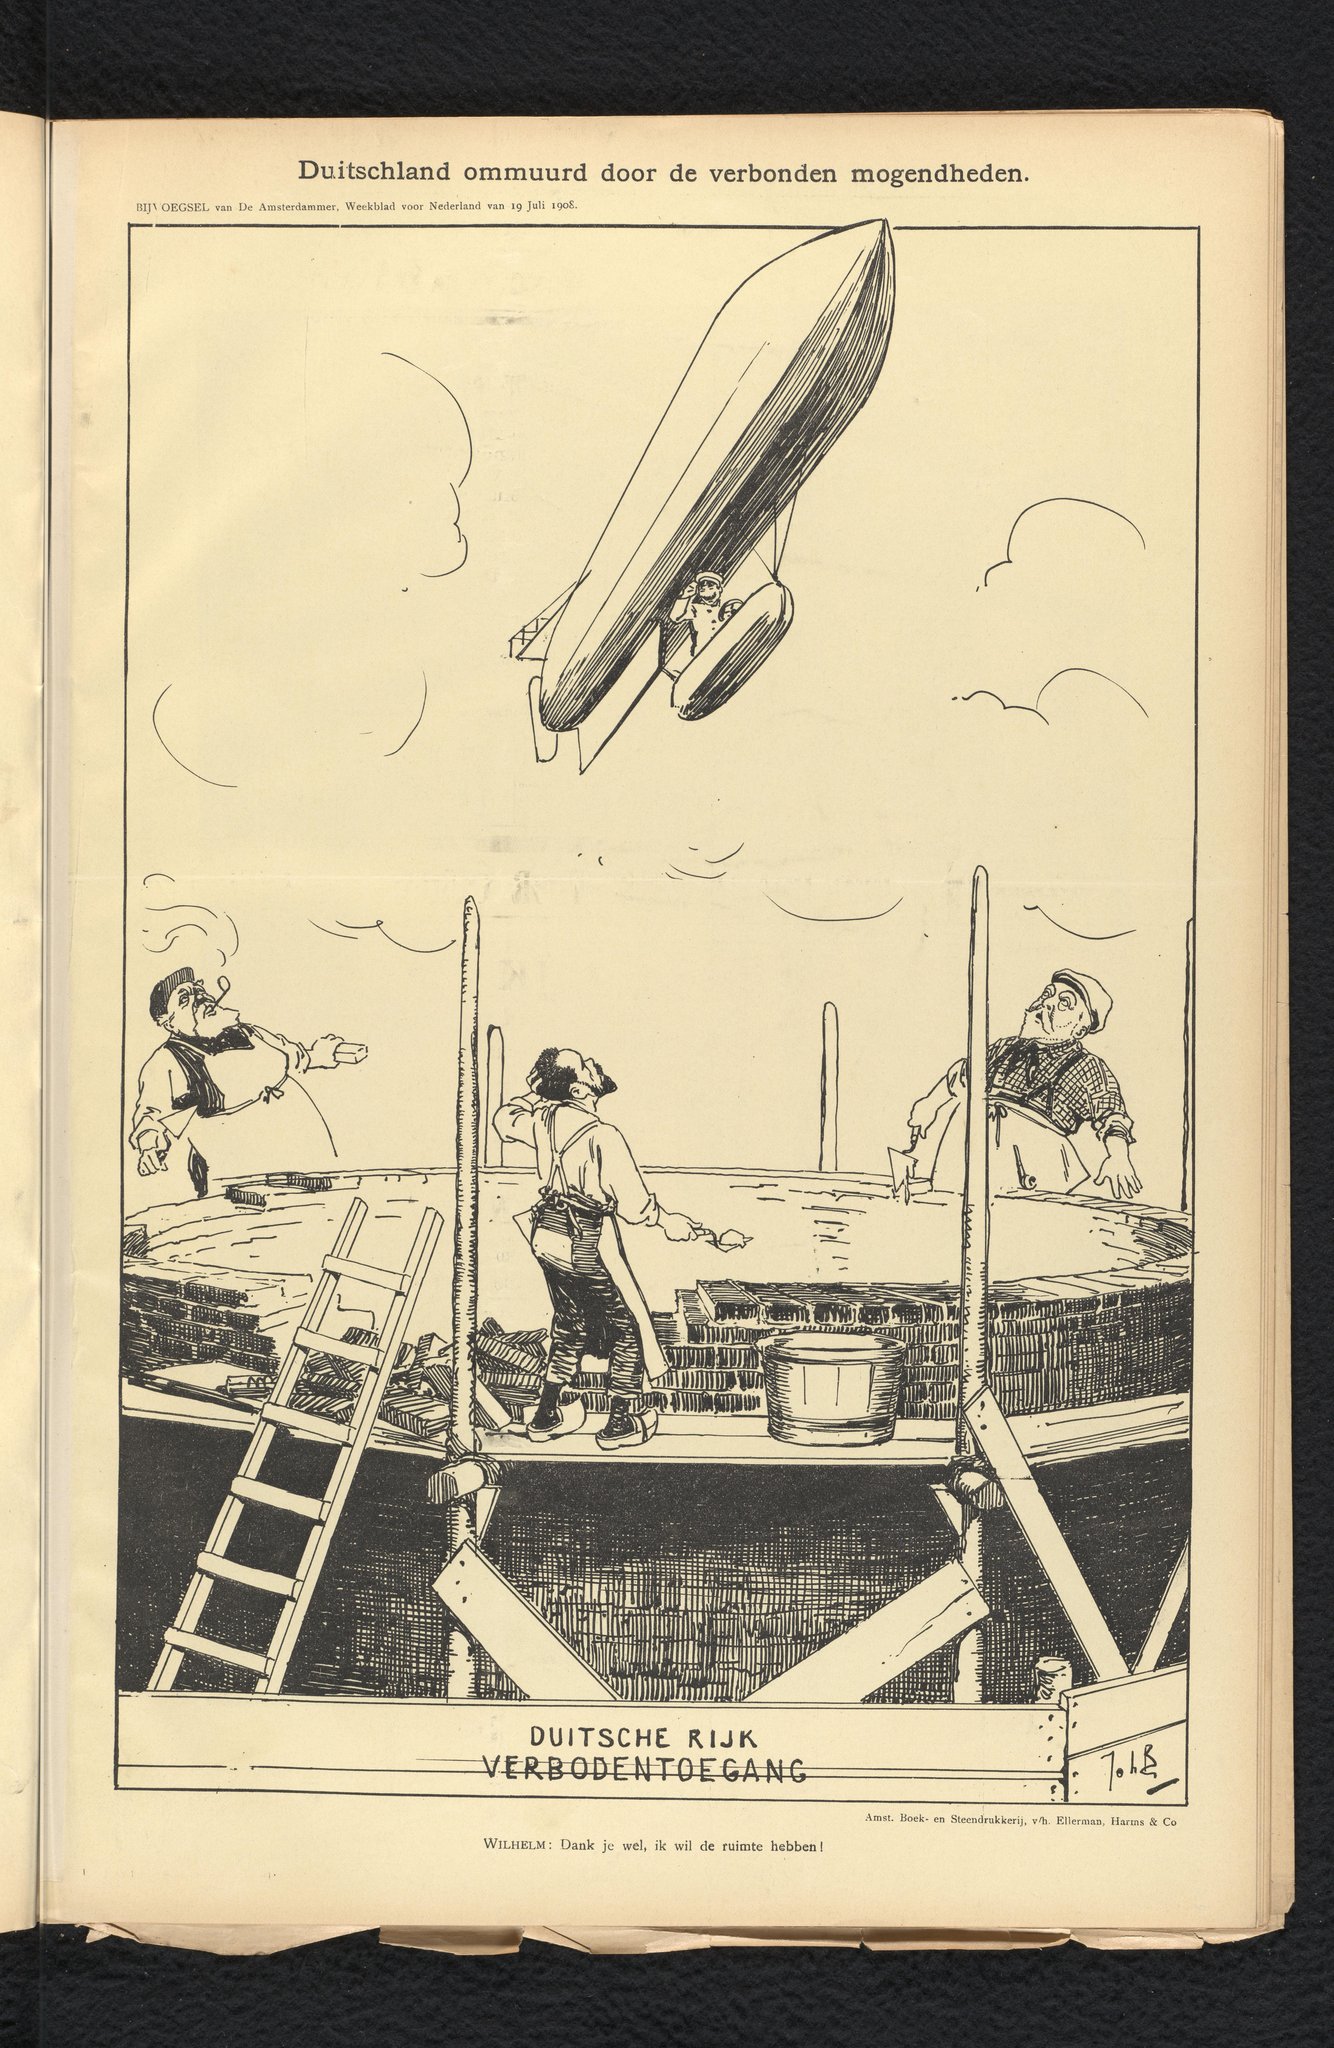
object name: cartoon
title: Duitschland ommuurd door de verbonden mogendheden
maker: johan braakensiek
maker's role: draughtsman, print maker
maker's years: 1858-1940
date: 1908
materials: paper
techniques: lithograph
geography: netherlands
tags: wilhelm ii (keizer van duitsland), personifications of countries, nations, states, districts, etc., 46c35 airship, zeppelin, brick-layer at work, political caricatures and satires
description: Als Duitsland ingemetseld wordt door omringende landen (Rusland, Engeland en Frankrijk) ontsnapt de Duitse keizer Wilhelm II met een zeppelin.